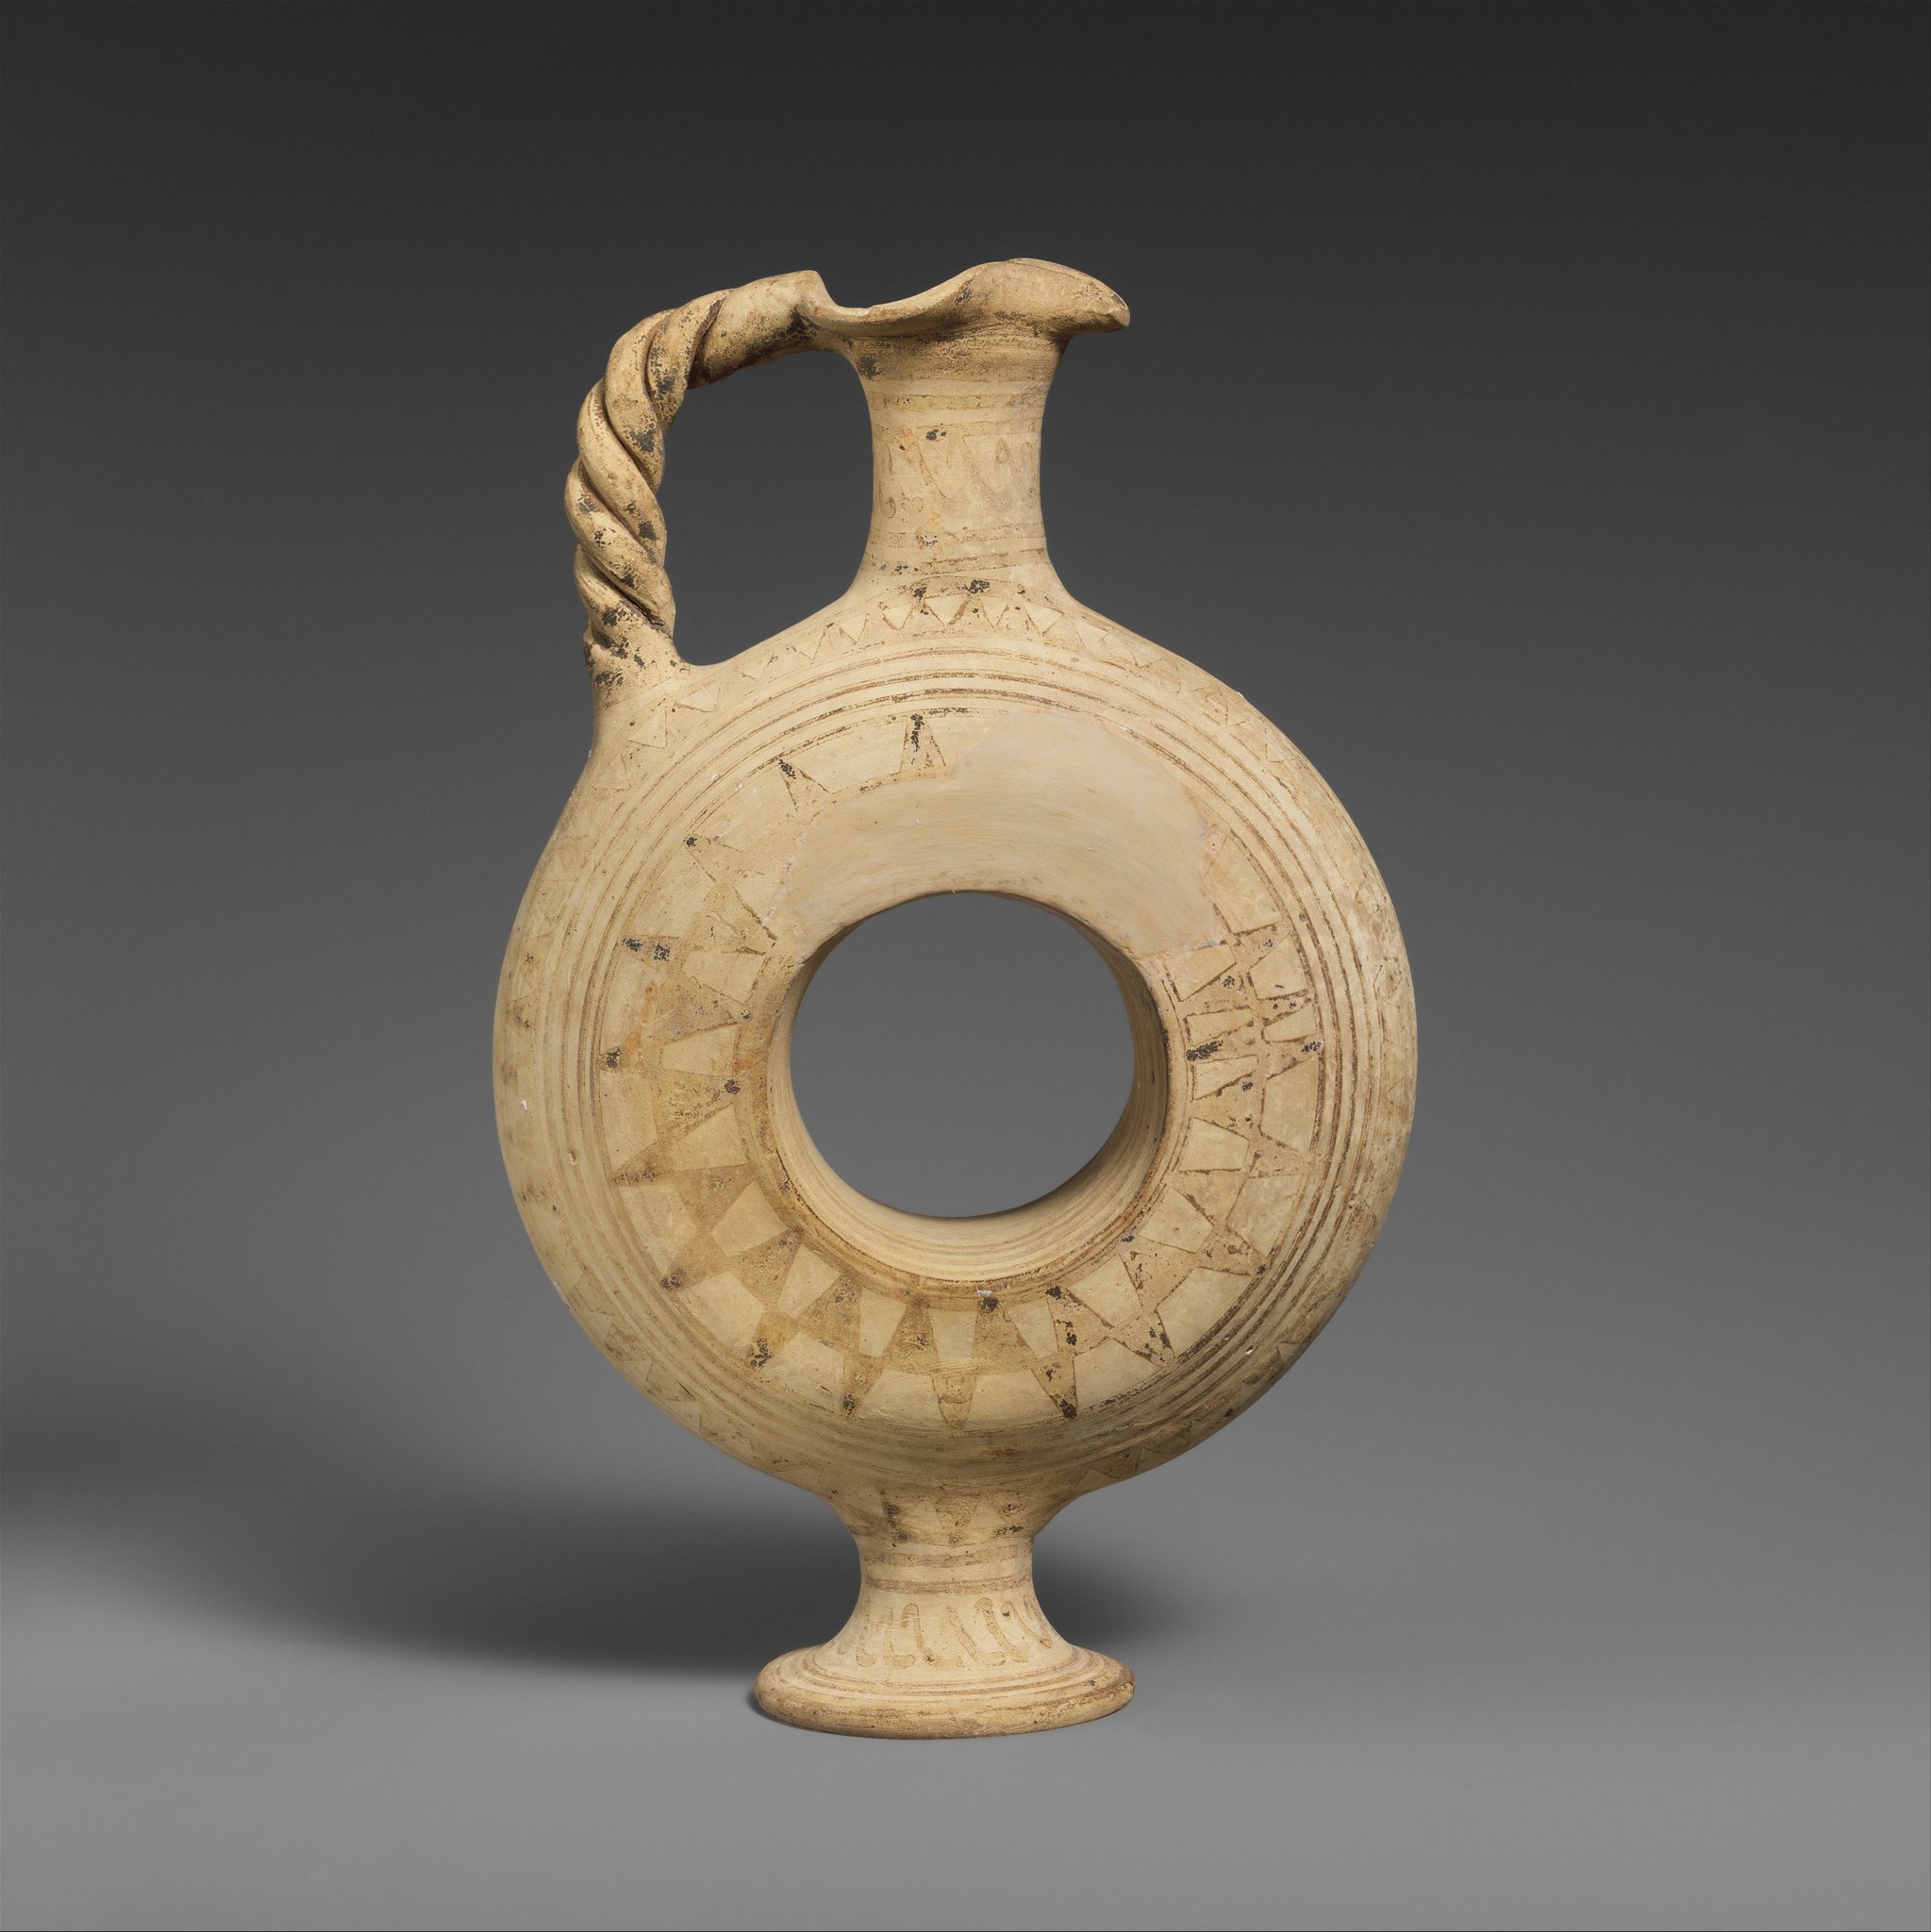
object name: ring vase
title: Terracotta ring vase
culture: greek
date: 800-701 BCE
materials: terracotta